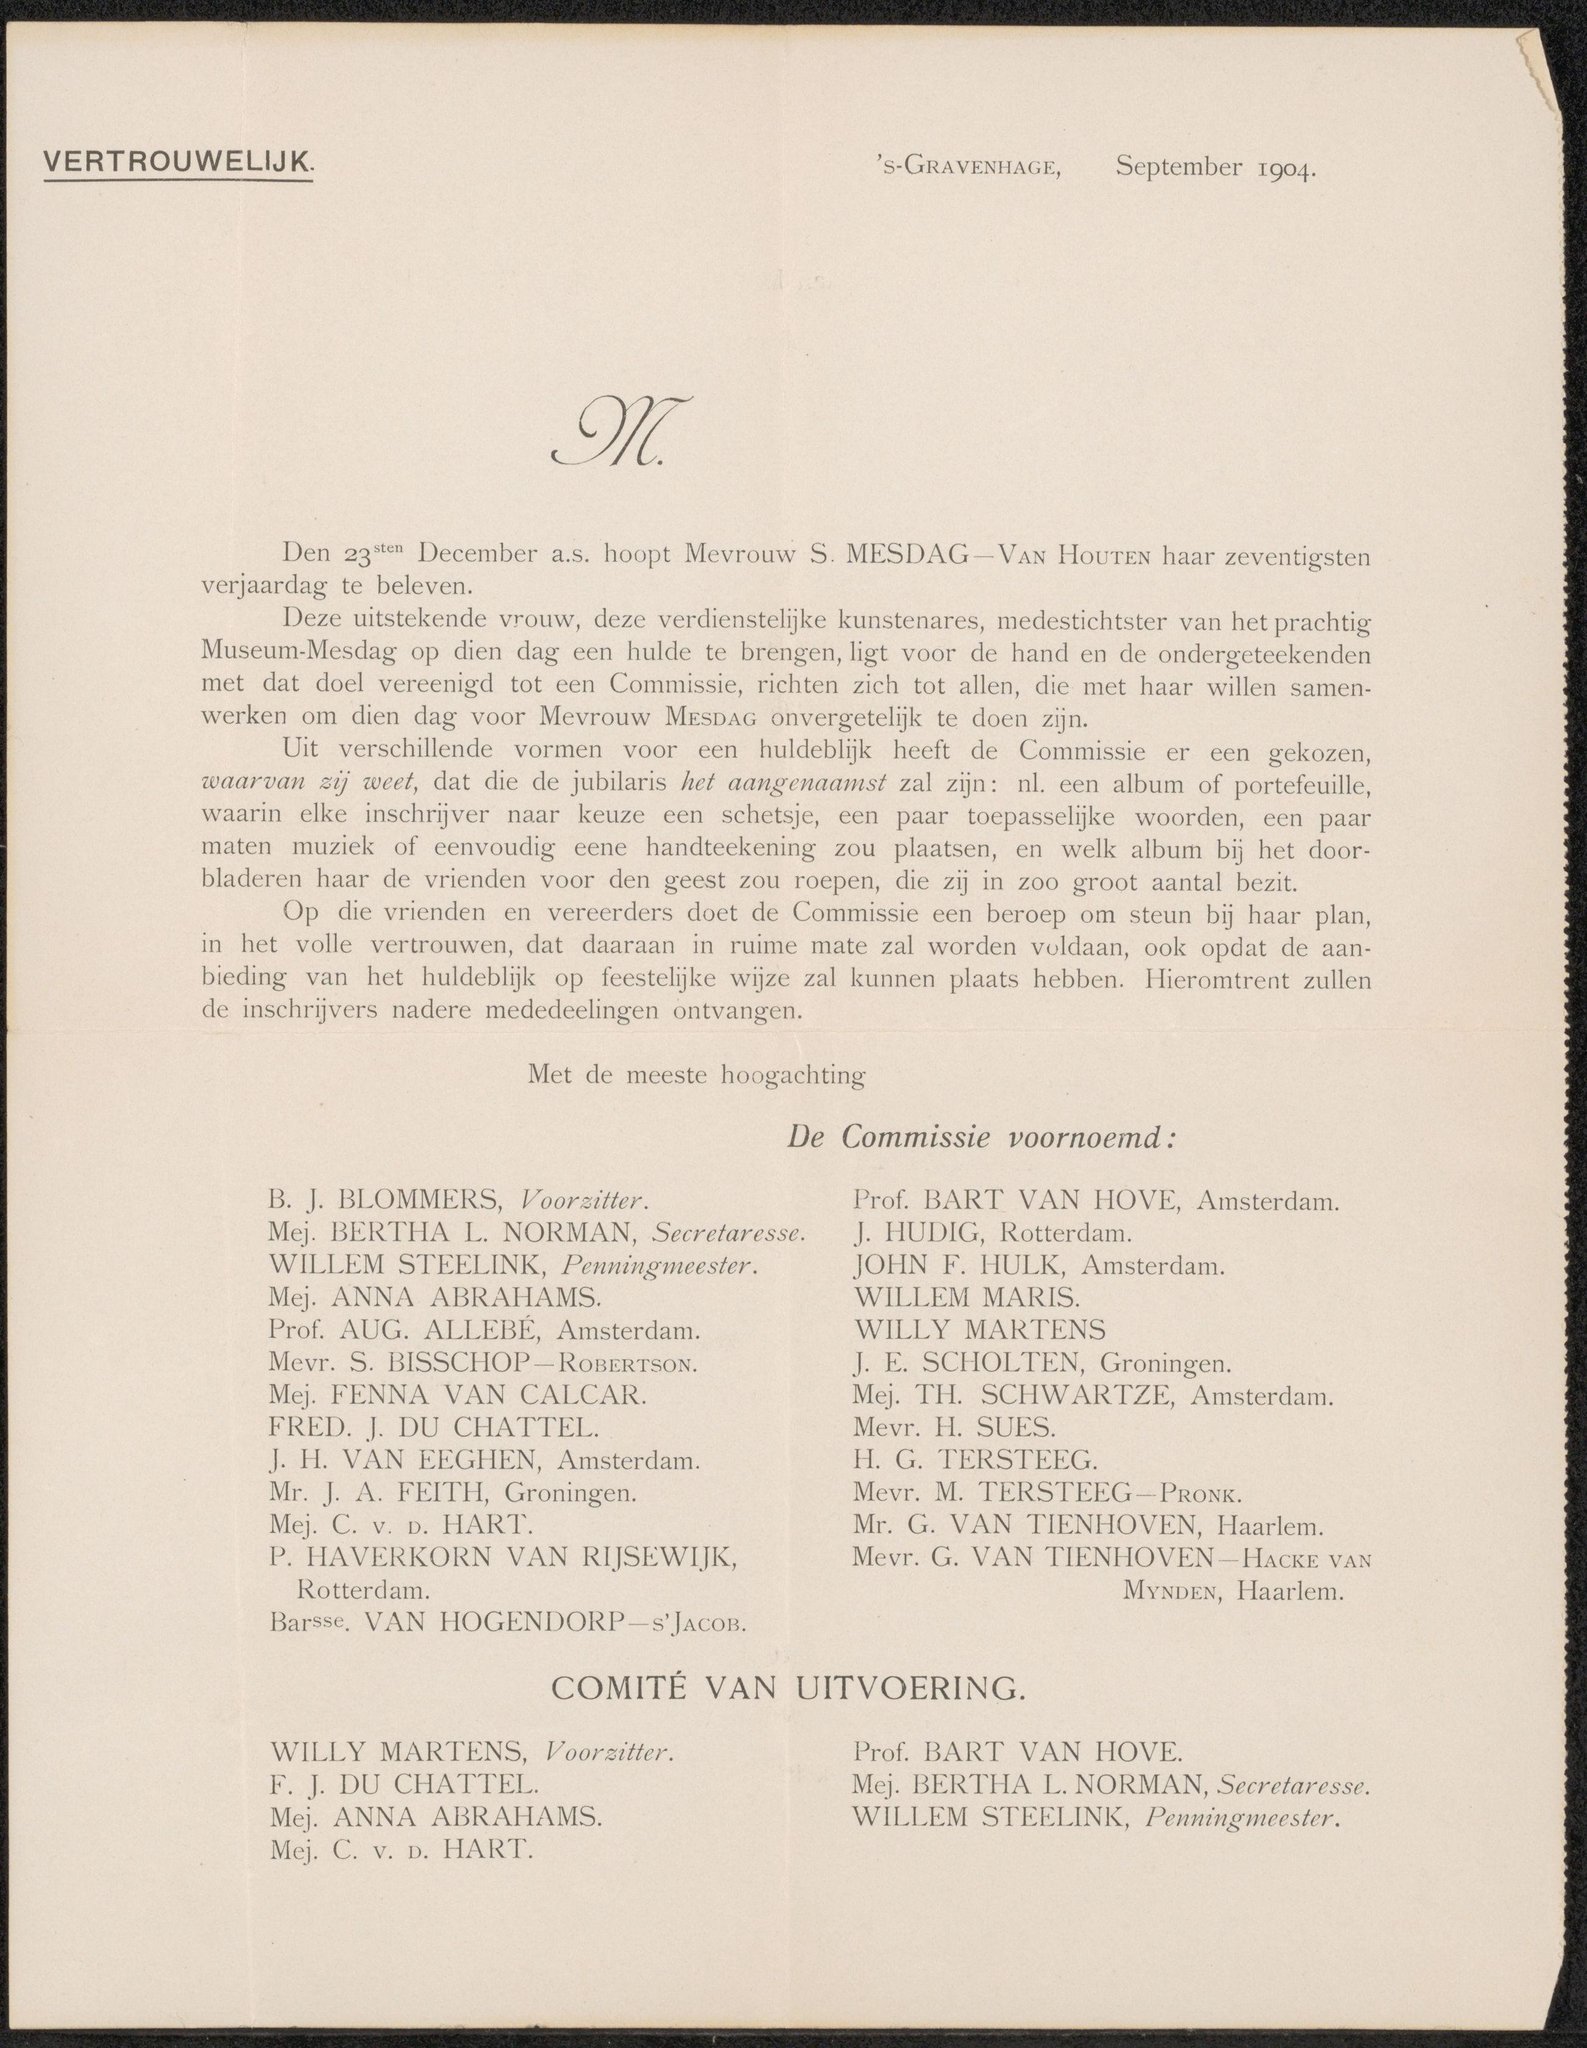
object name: letter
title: Brief aan anoniem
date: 1904-1909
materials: paper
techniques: printing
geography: the hague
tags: voorburg, print maker, draughtsman, willem steelink (ii), the hague, painter, sientje mesdag-van houten, drawing, music, money